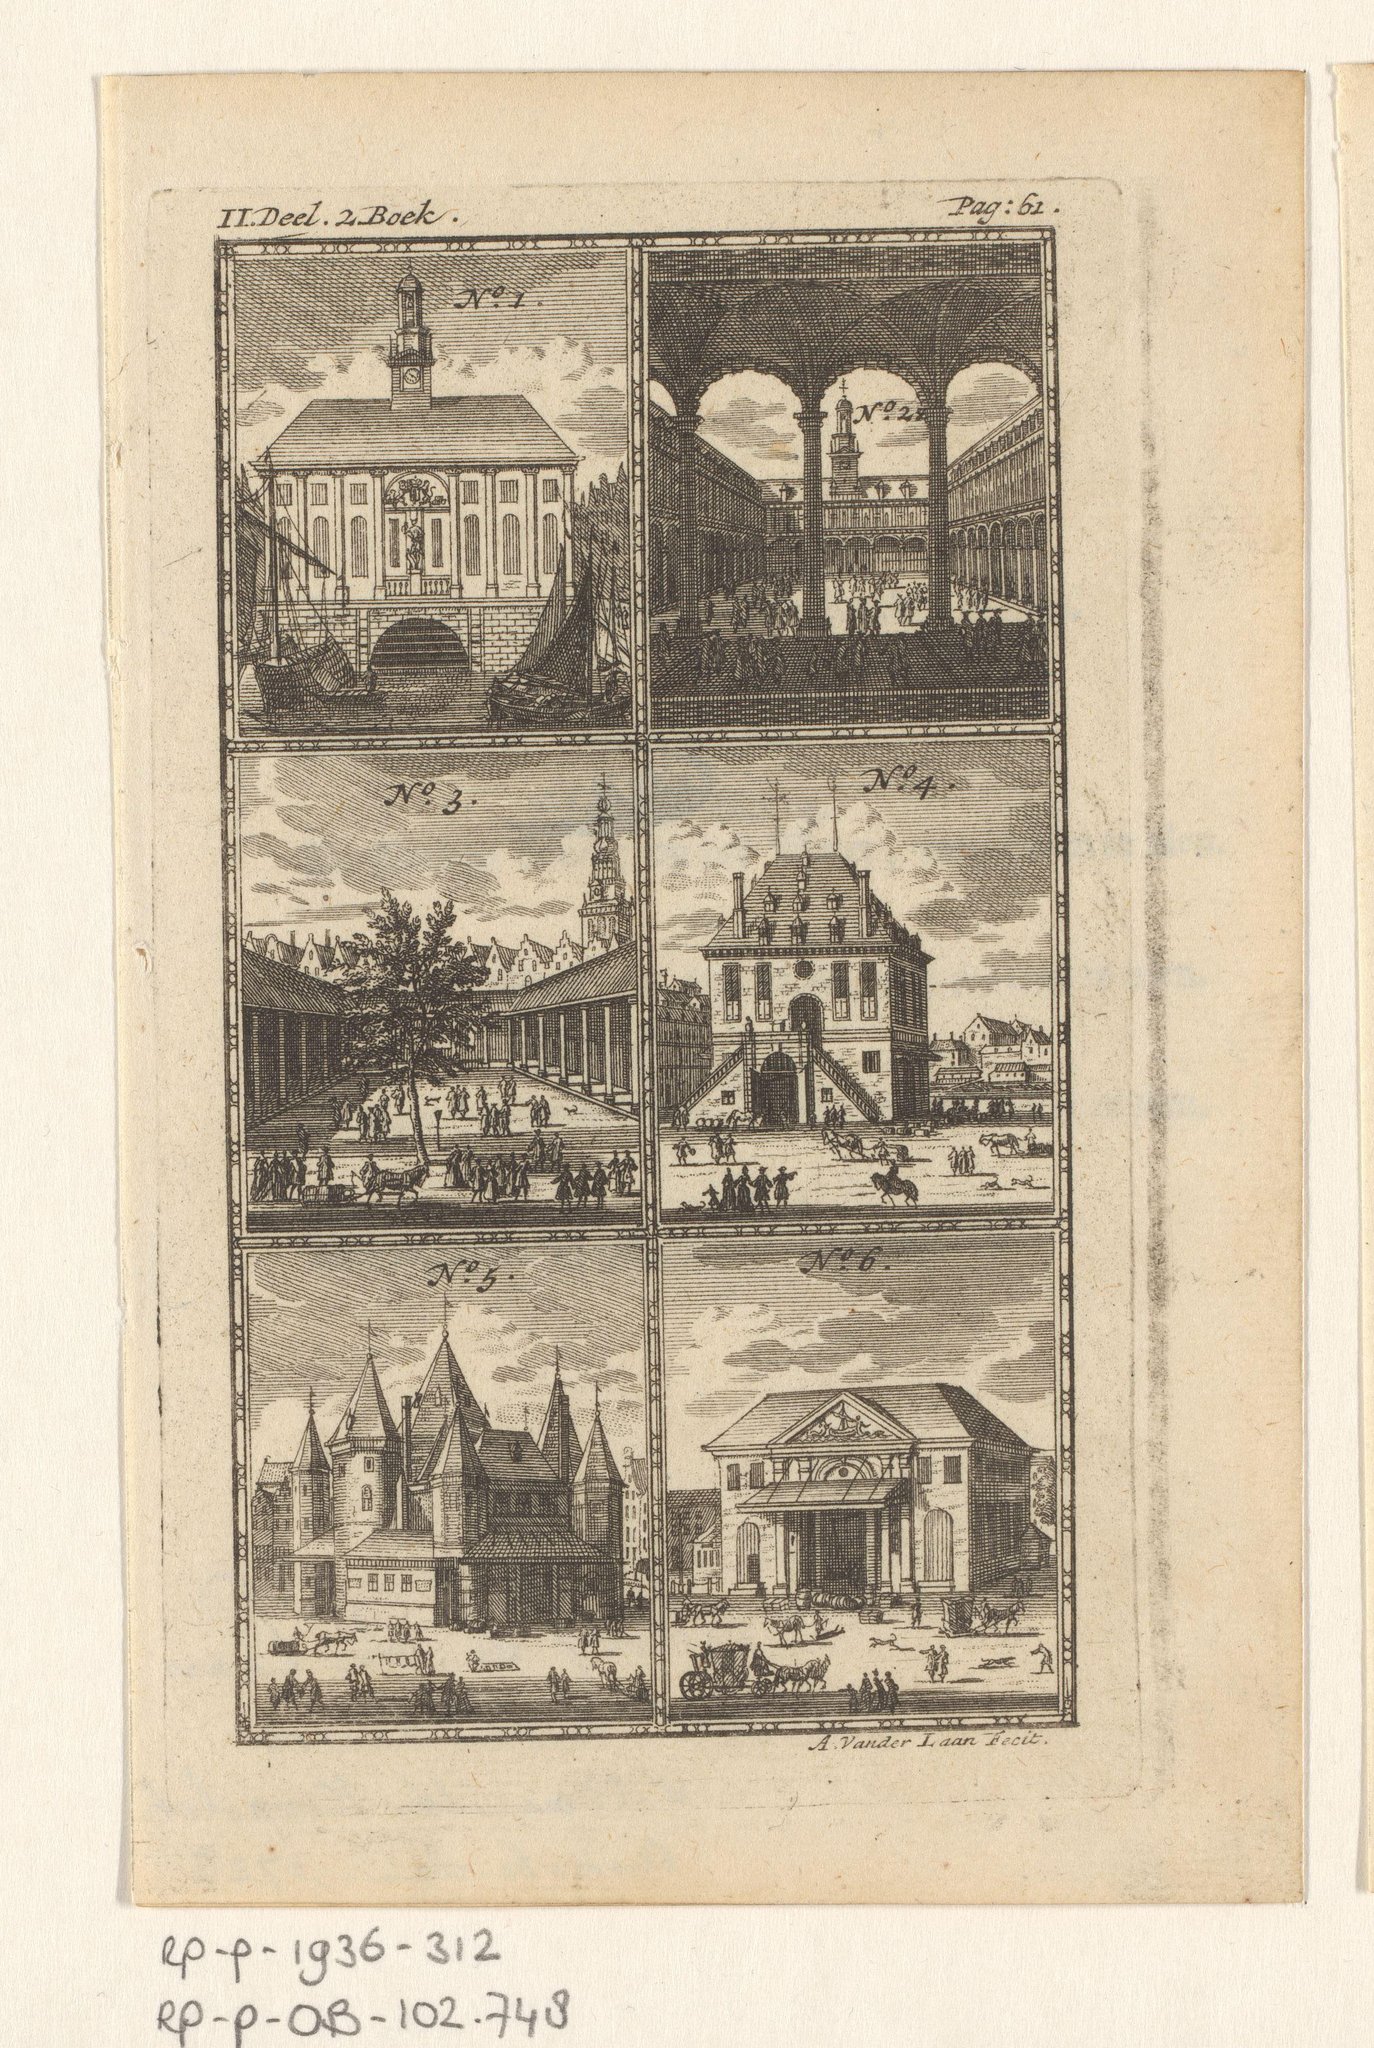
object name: text sheet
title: Tekstblad bij boekillustratie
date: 1723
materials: paper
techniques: letterpress printing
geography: amsterdam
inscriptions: collector's mark: Lugt 2228, collector's mark: Lugt 2760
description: Tekstblad uit: Leuve, Roeland van. 's Waerelds koopslot of De Amsteldamse beurs. Amsterdam: Jacobus Verheyden (I), 1723.